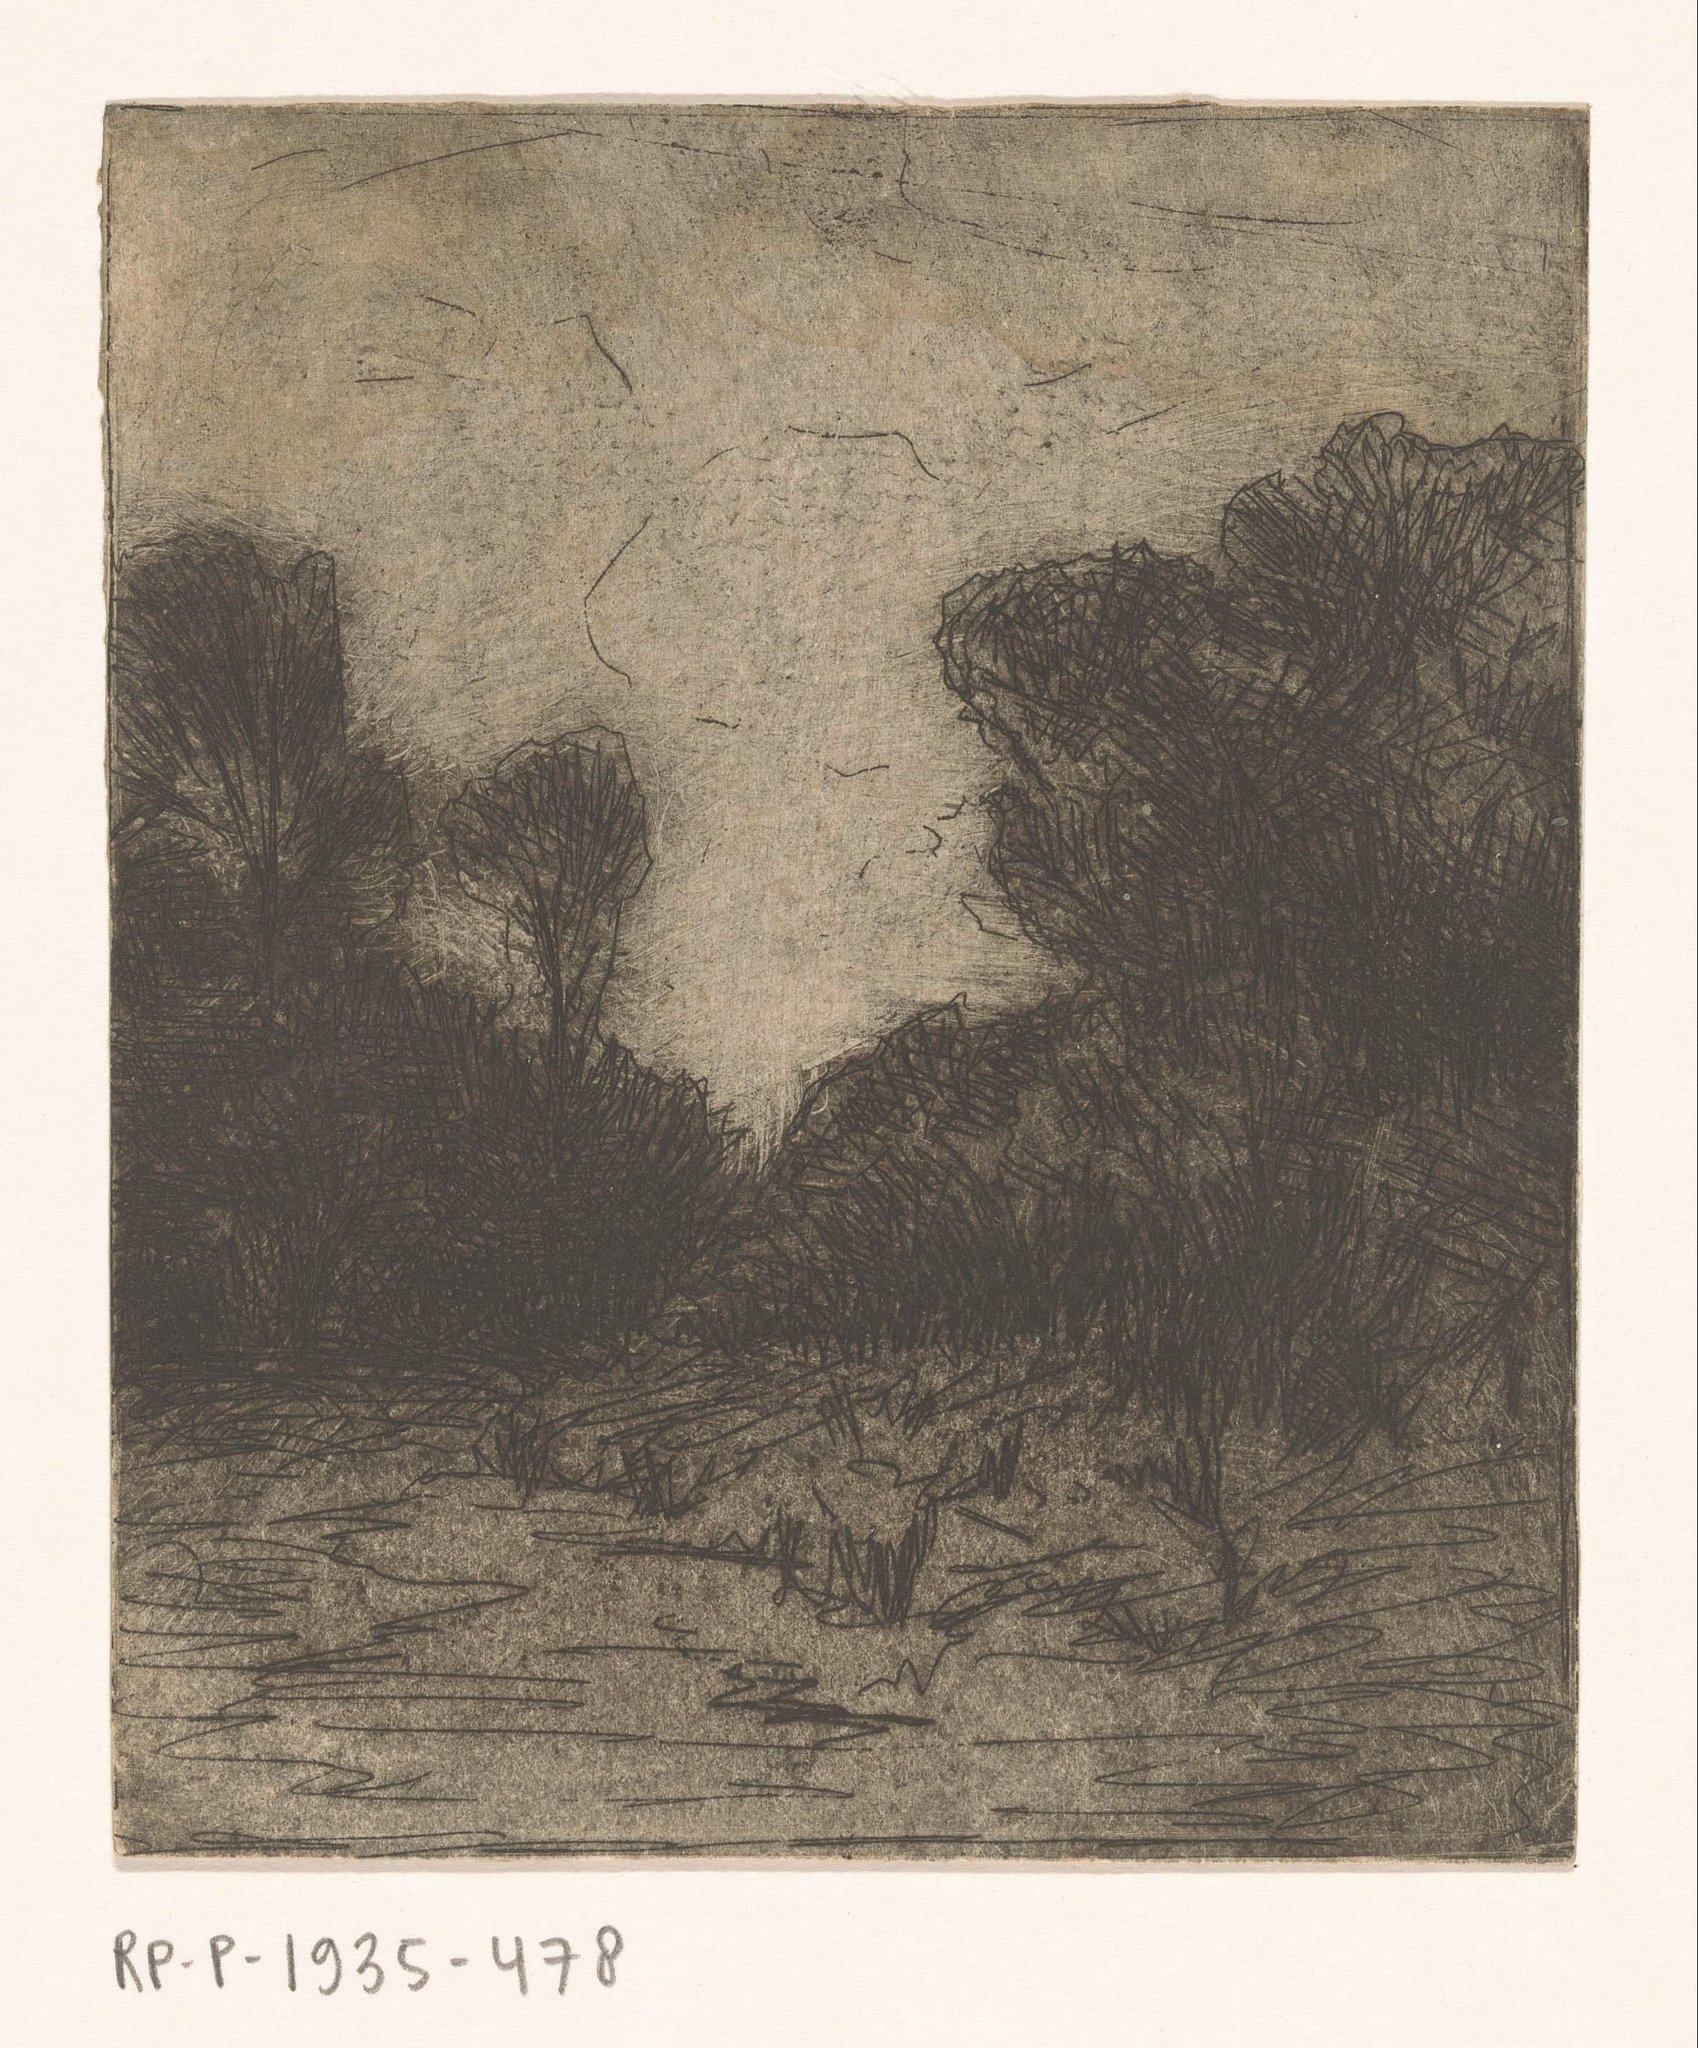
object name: print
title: Landschap met bomen bij avond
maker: hermannus adrianus van oosterzee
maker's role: draughtsman, painter, print maker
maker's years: 1863-1933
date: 1873-1933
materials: paper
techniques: etching, intaglio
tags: trees, evening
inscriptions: collector's mark: Lugt 2228